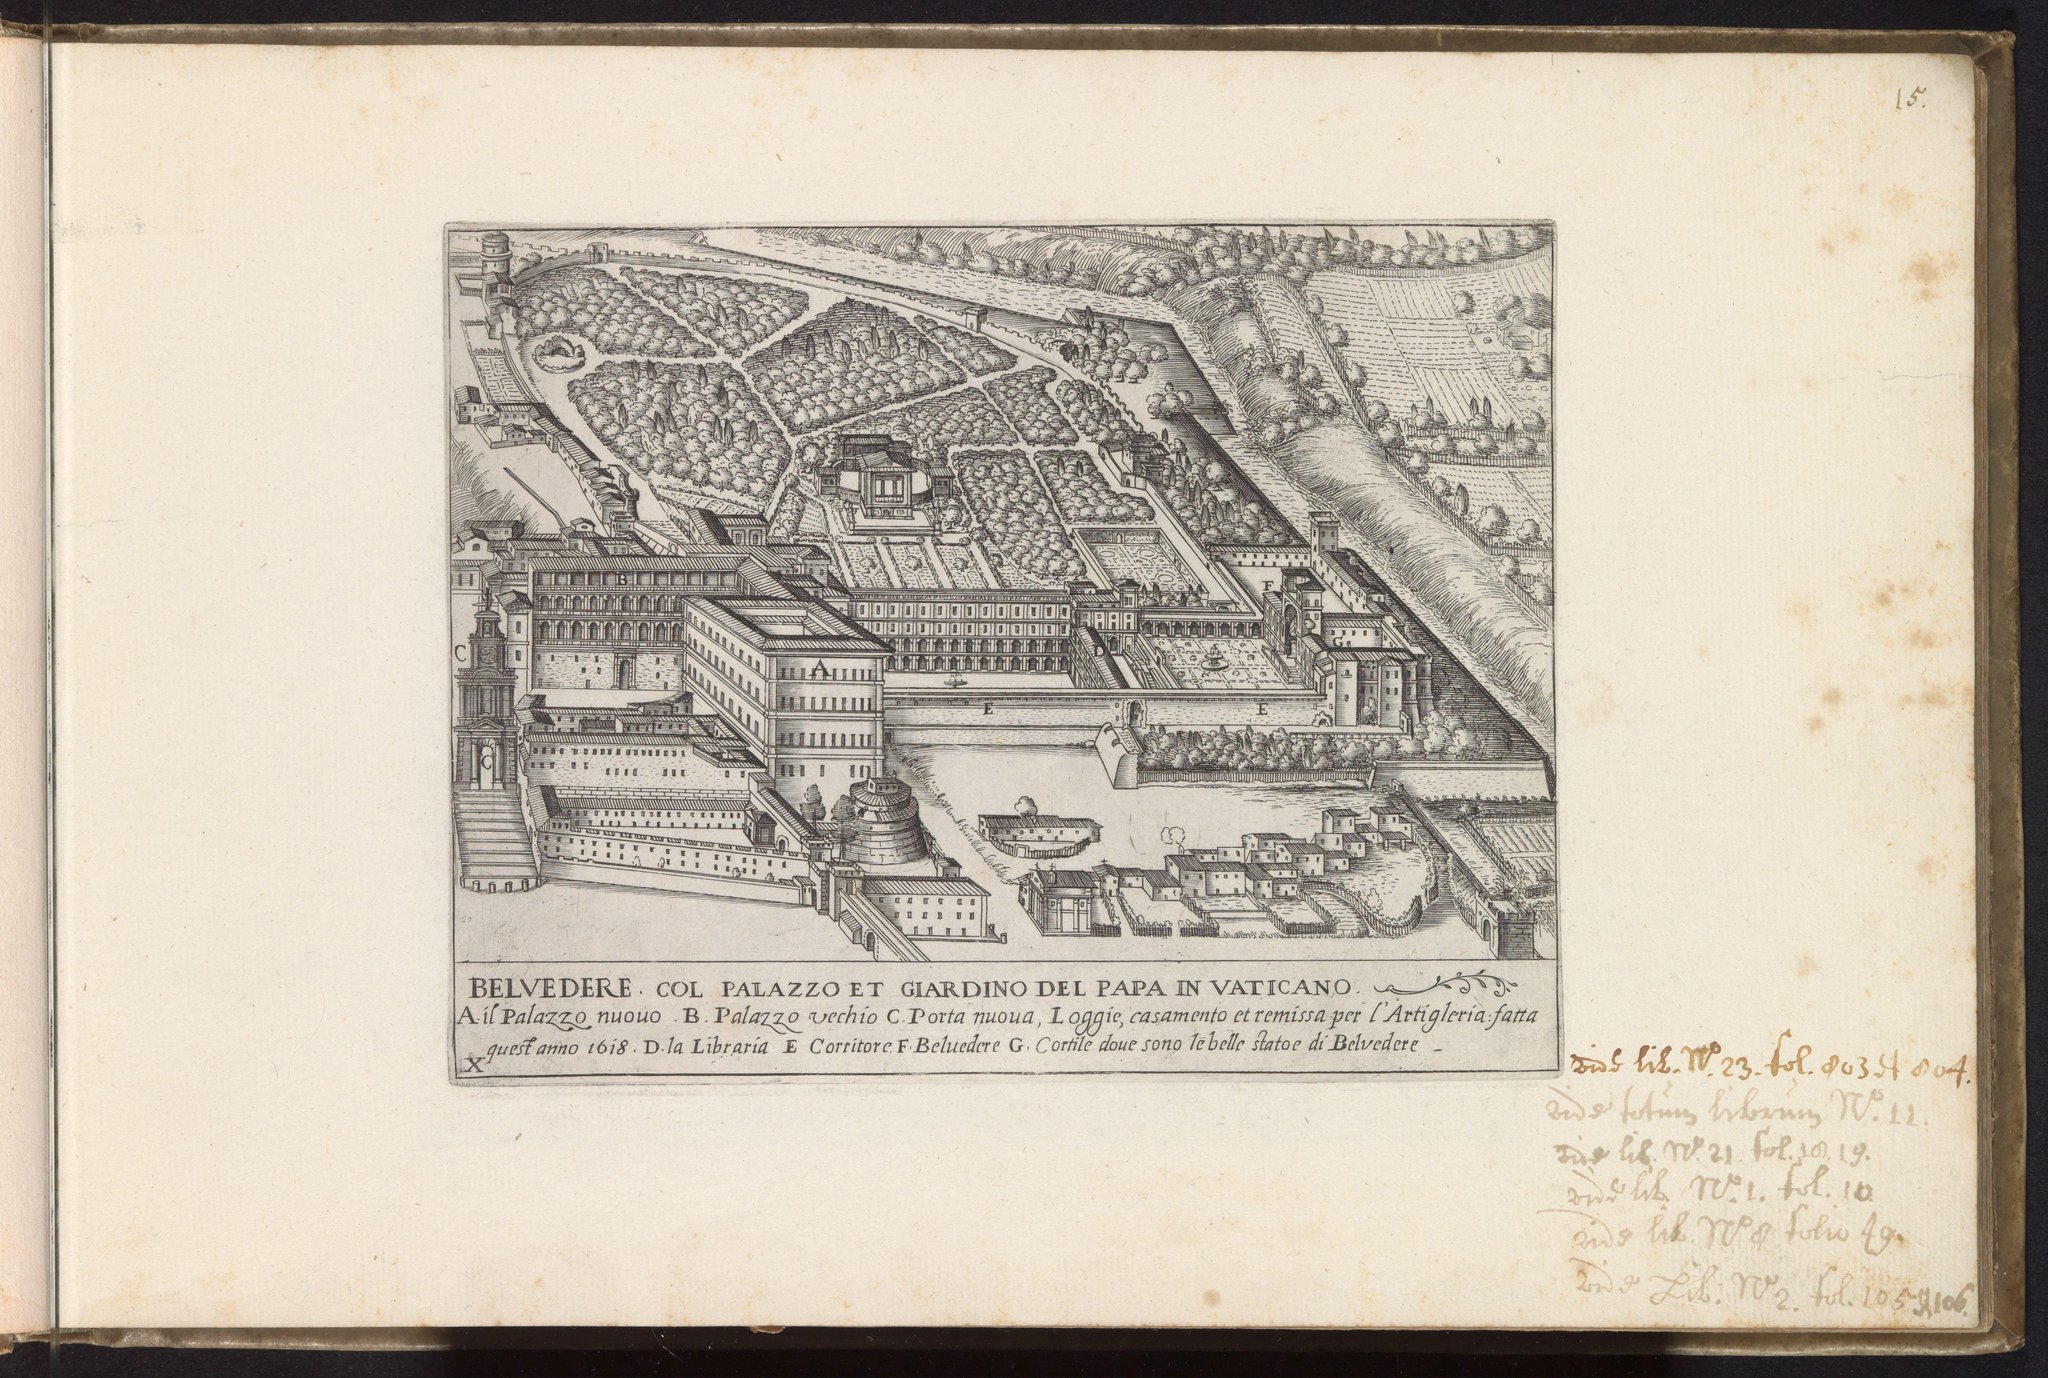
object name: album leaf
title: Cortile del Belvedere, het Apostolisch Paleis en de tuinen te Vaticaanstad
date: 1618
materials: paper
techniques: engraving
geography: rome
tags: city-view, and landscape with man-made constructions, garden, palace, representation of real building (either existing or having existed)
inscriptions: inscription: ‘Ende lib. No. 23. fol. 803 et 804...’, number: ‘15’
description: Gezicht op het Vaticaan, met het Apostolisch Paleis, de tuinen en de Cortile del Belvedere. Titel in het Italiaans en een verklarende lijst met letters in de ondermarge. Prent maakt deel uit van een album.